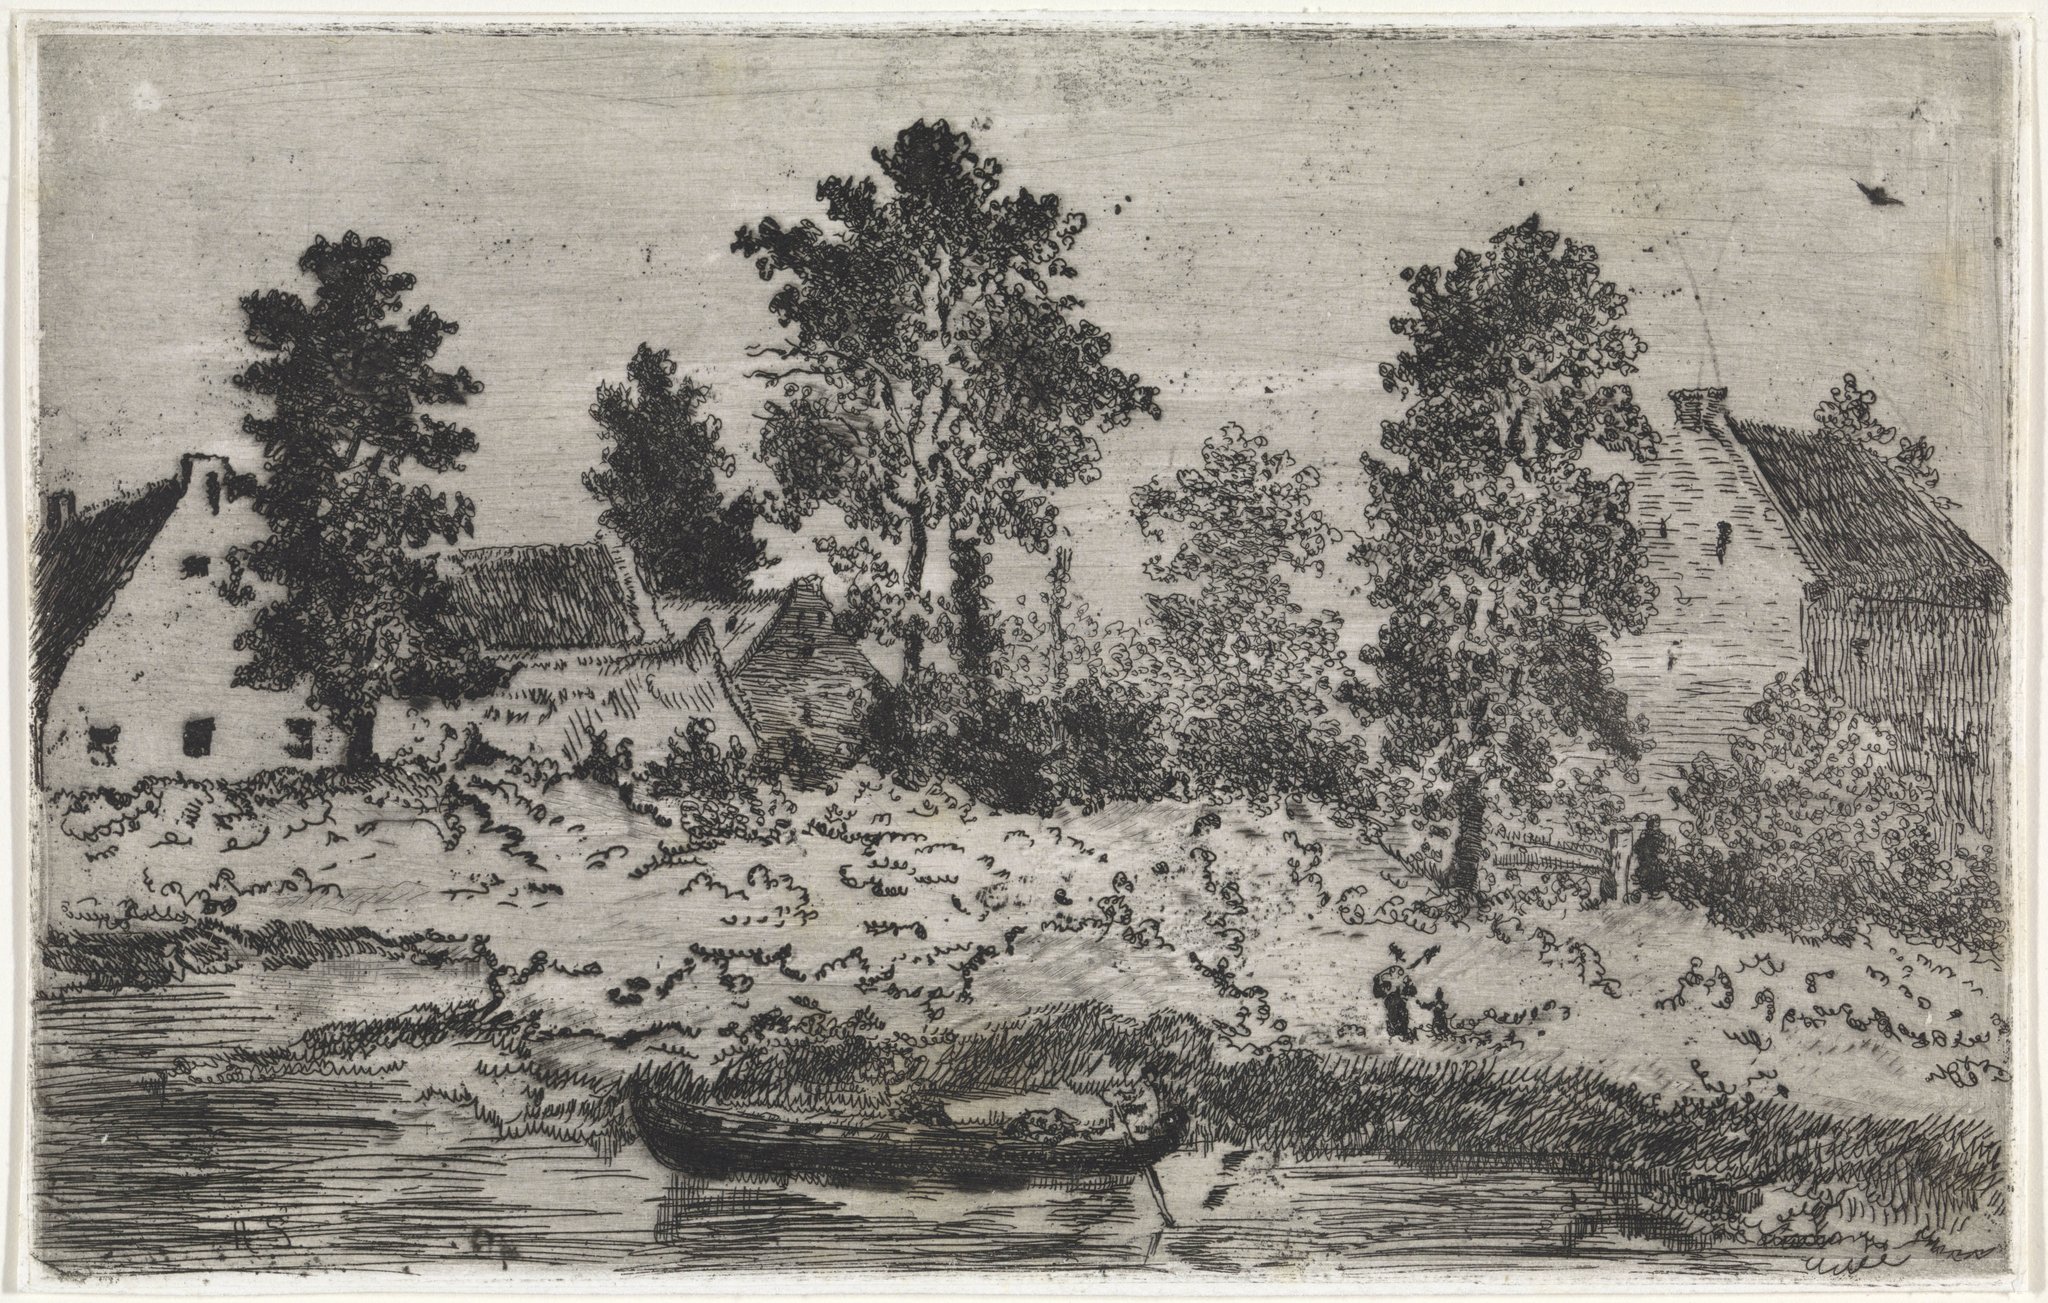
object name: print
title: Huizen aan de river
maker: arnoud schaepkens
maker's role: print maker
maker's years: 1816-1904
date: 1855-1904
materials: paper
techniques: drypoint, etching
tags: landscapes with waters, waterscapes, seascapes (in the temperate zone)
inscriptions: collector's mark: Lugt 2228